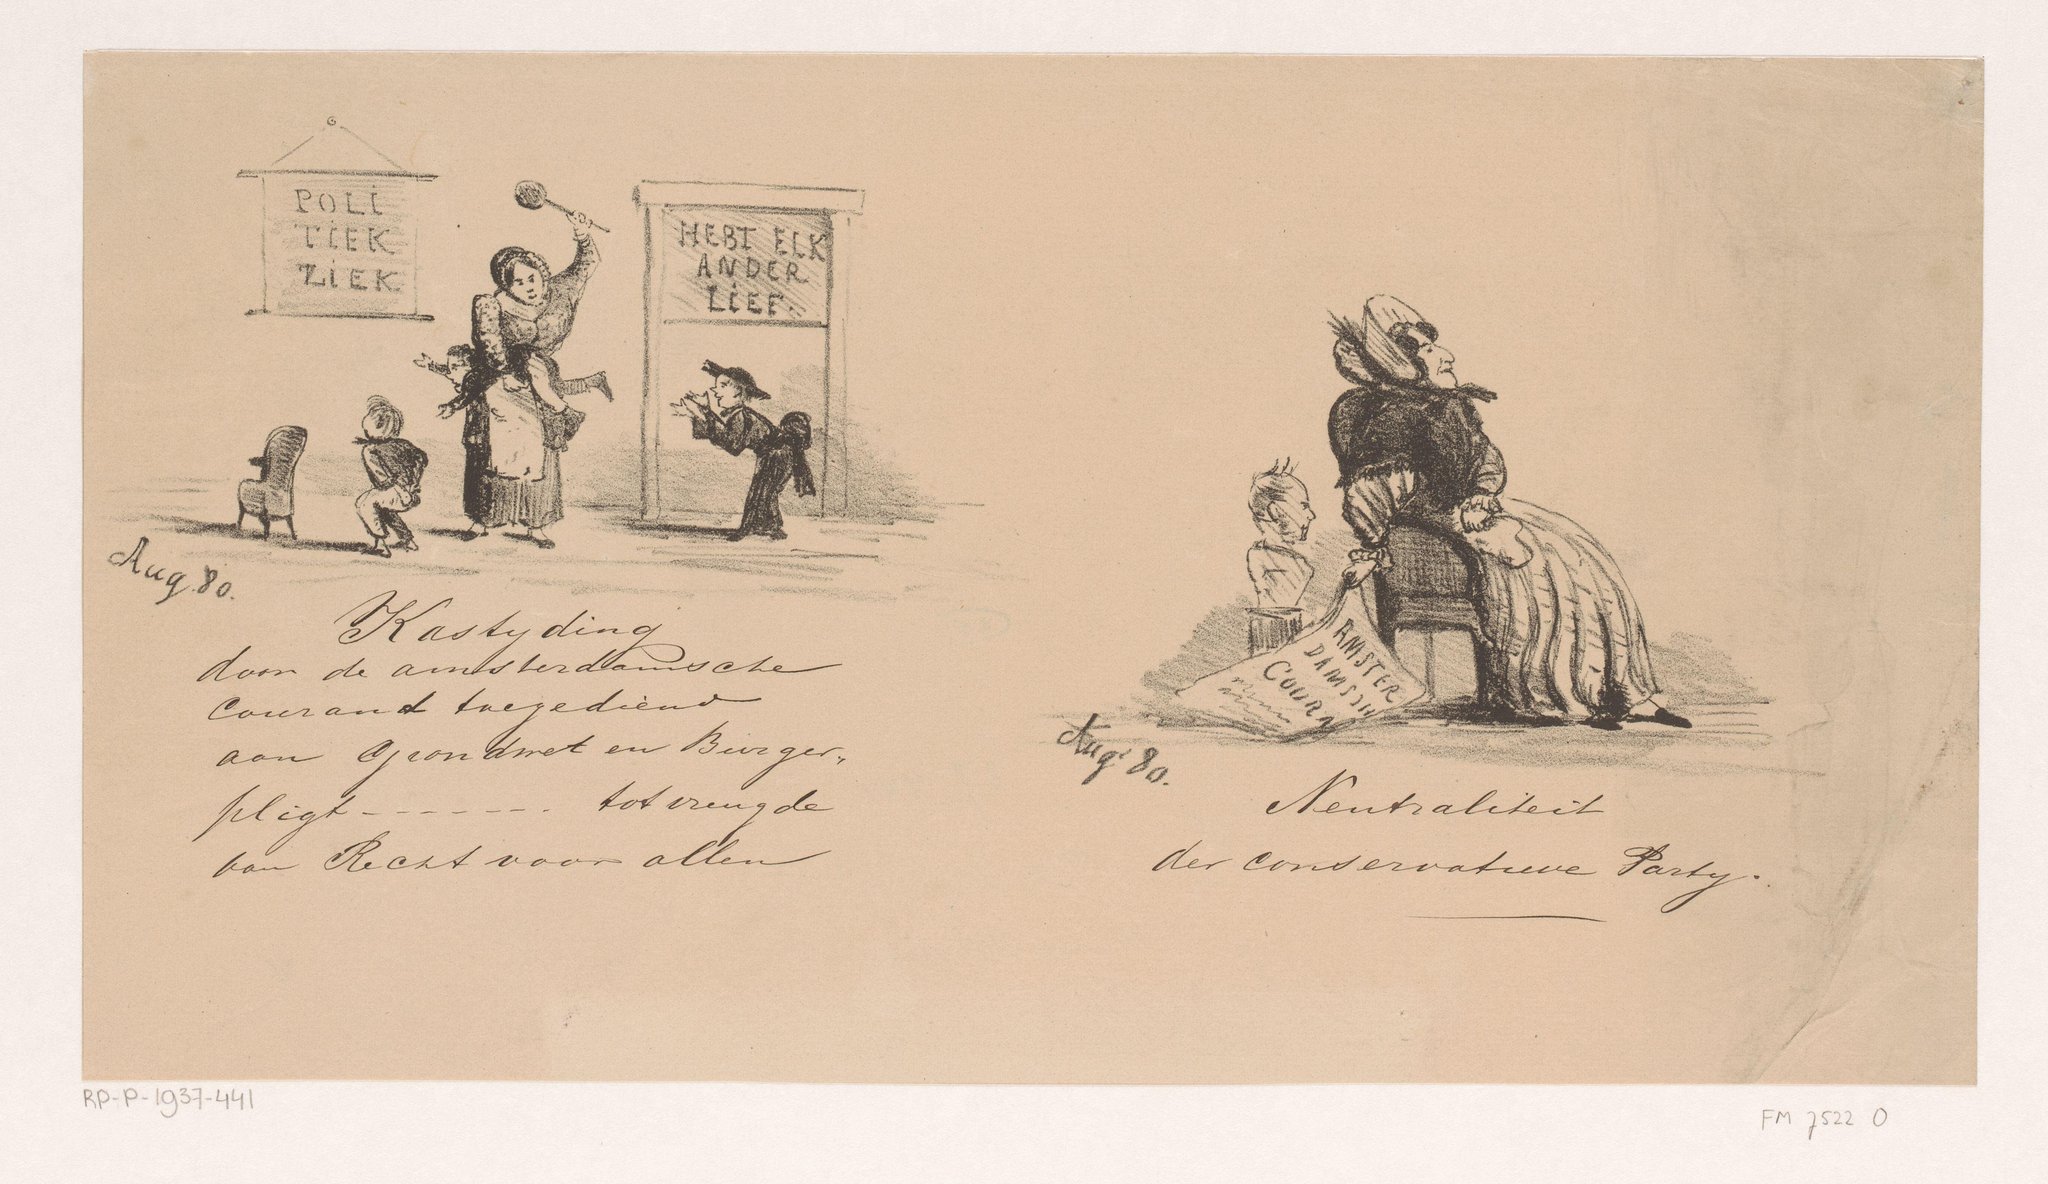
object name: cartoon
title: Kastijding door de Amsterdamsche Courant toegediend aan Grondwet en Burgerpligt (...) tot vreugde van Recht voor allen / Neutraliteit der conservatieve Partij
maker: piet hein testas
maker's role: print maker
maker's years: 1826-1905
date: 1808-1880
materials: paper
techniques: lithograph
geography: netherlands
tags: voting, election, spanking, drubbing (of naughty children)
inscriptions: collector's mark: Lugt 2228, collector's mark: Lugt 2760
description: Links geeft een moeder haar twee kinderen billenkoek, terwijl een derde kind lachend toekijkt. Rechts zit een stoïcijns kijkende vrouw.